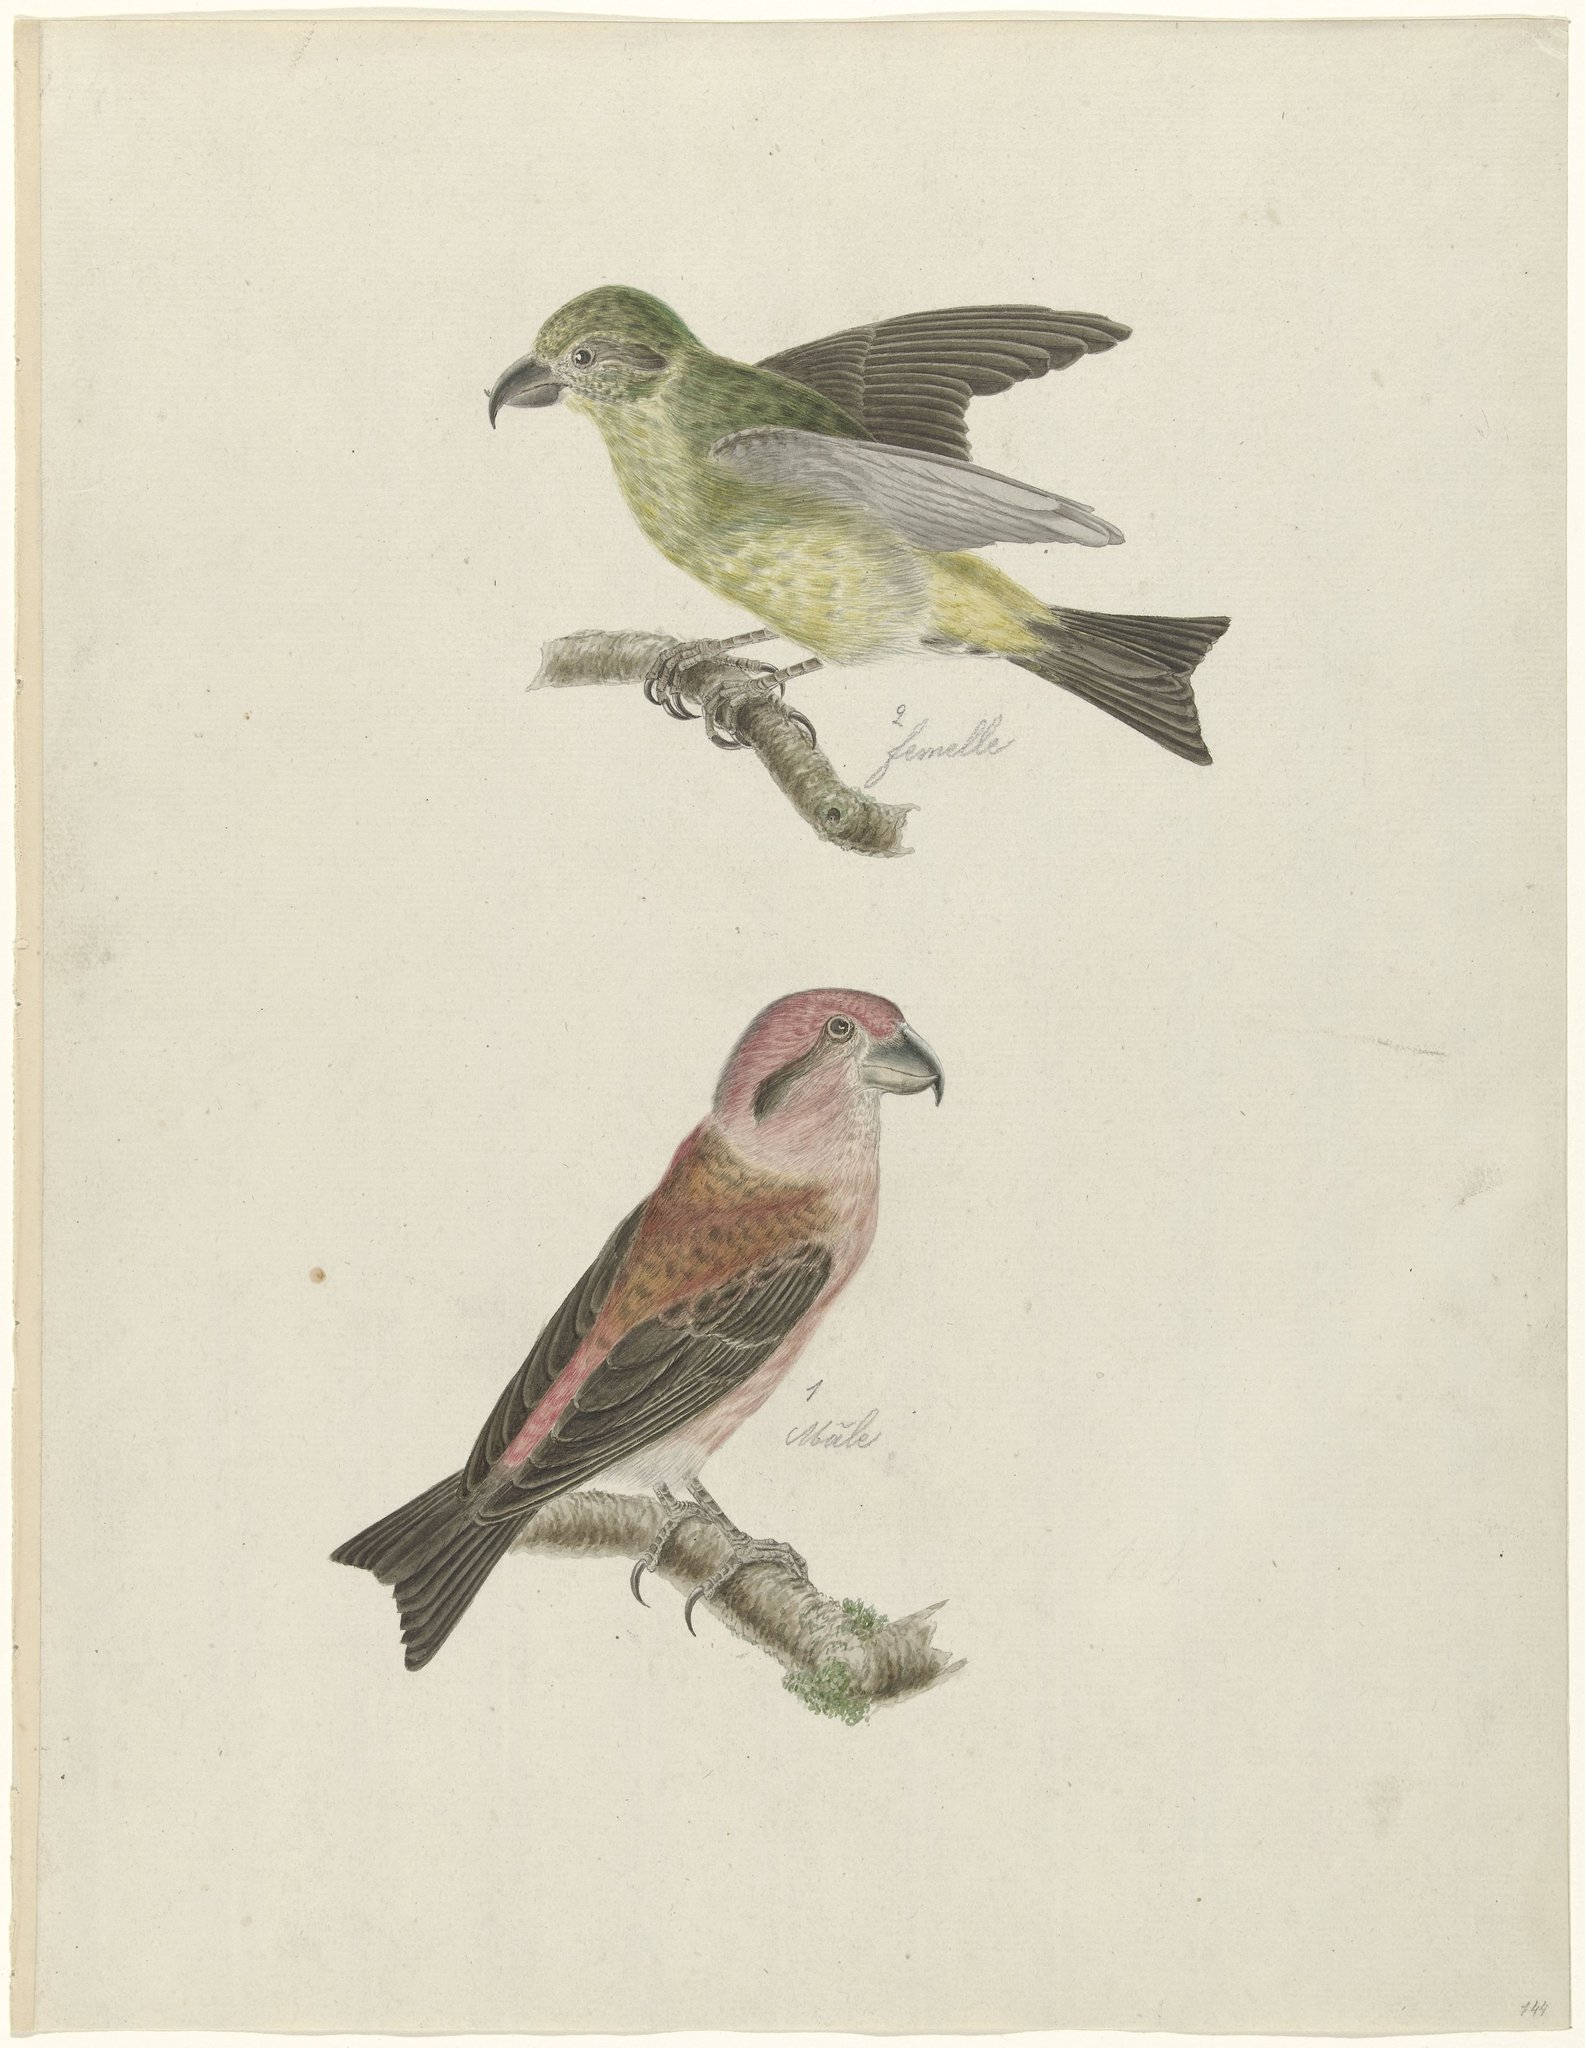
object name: watercolor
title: Twee Kruisbekken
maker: christiaan sepp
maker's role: draughtsman, print maker, publisher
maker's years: 1720-1775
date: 1730-1775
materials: paper, watercolor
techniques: brush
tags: groups of birds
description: Twee vogels, beide apart op een takje zittend. Opschrift boven: 2 femelle; onder: 1 Male.